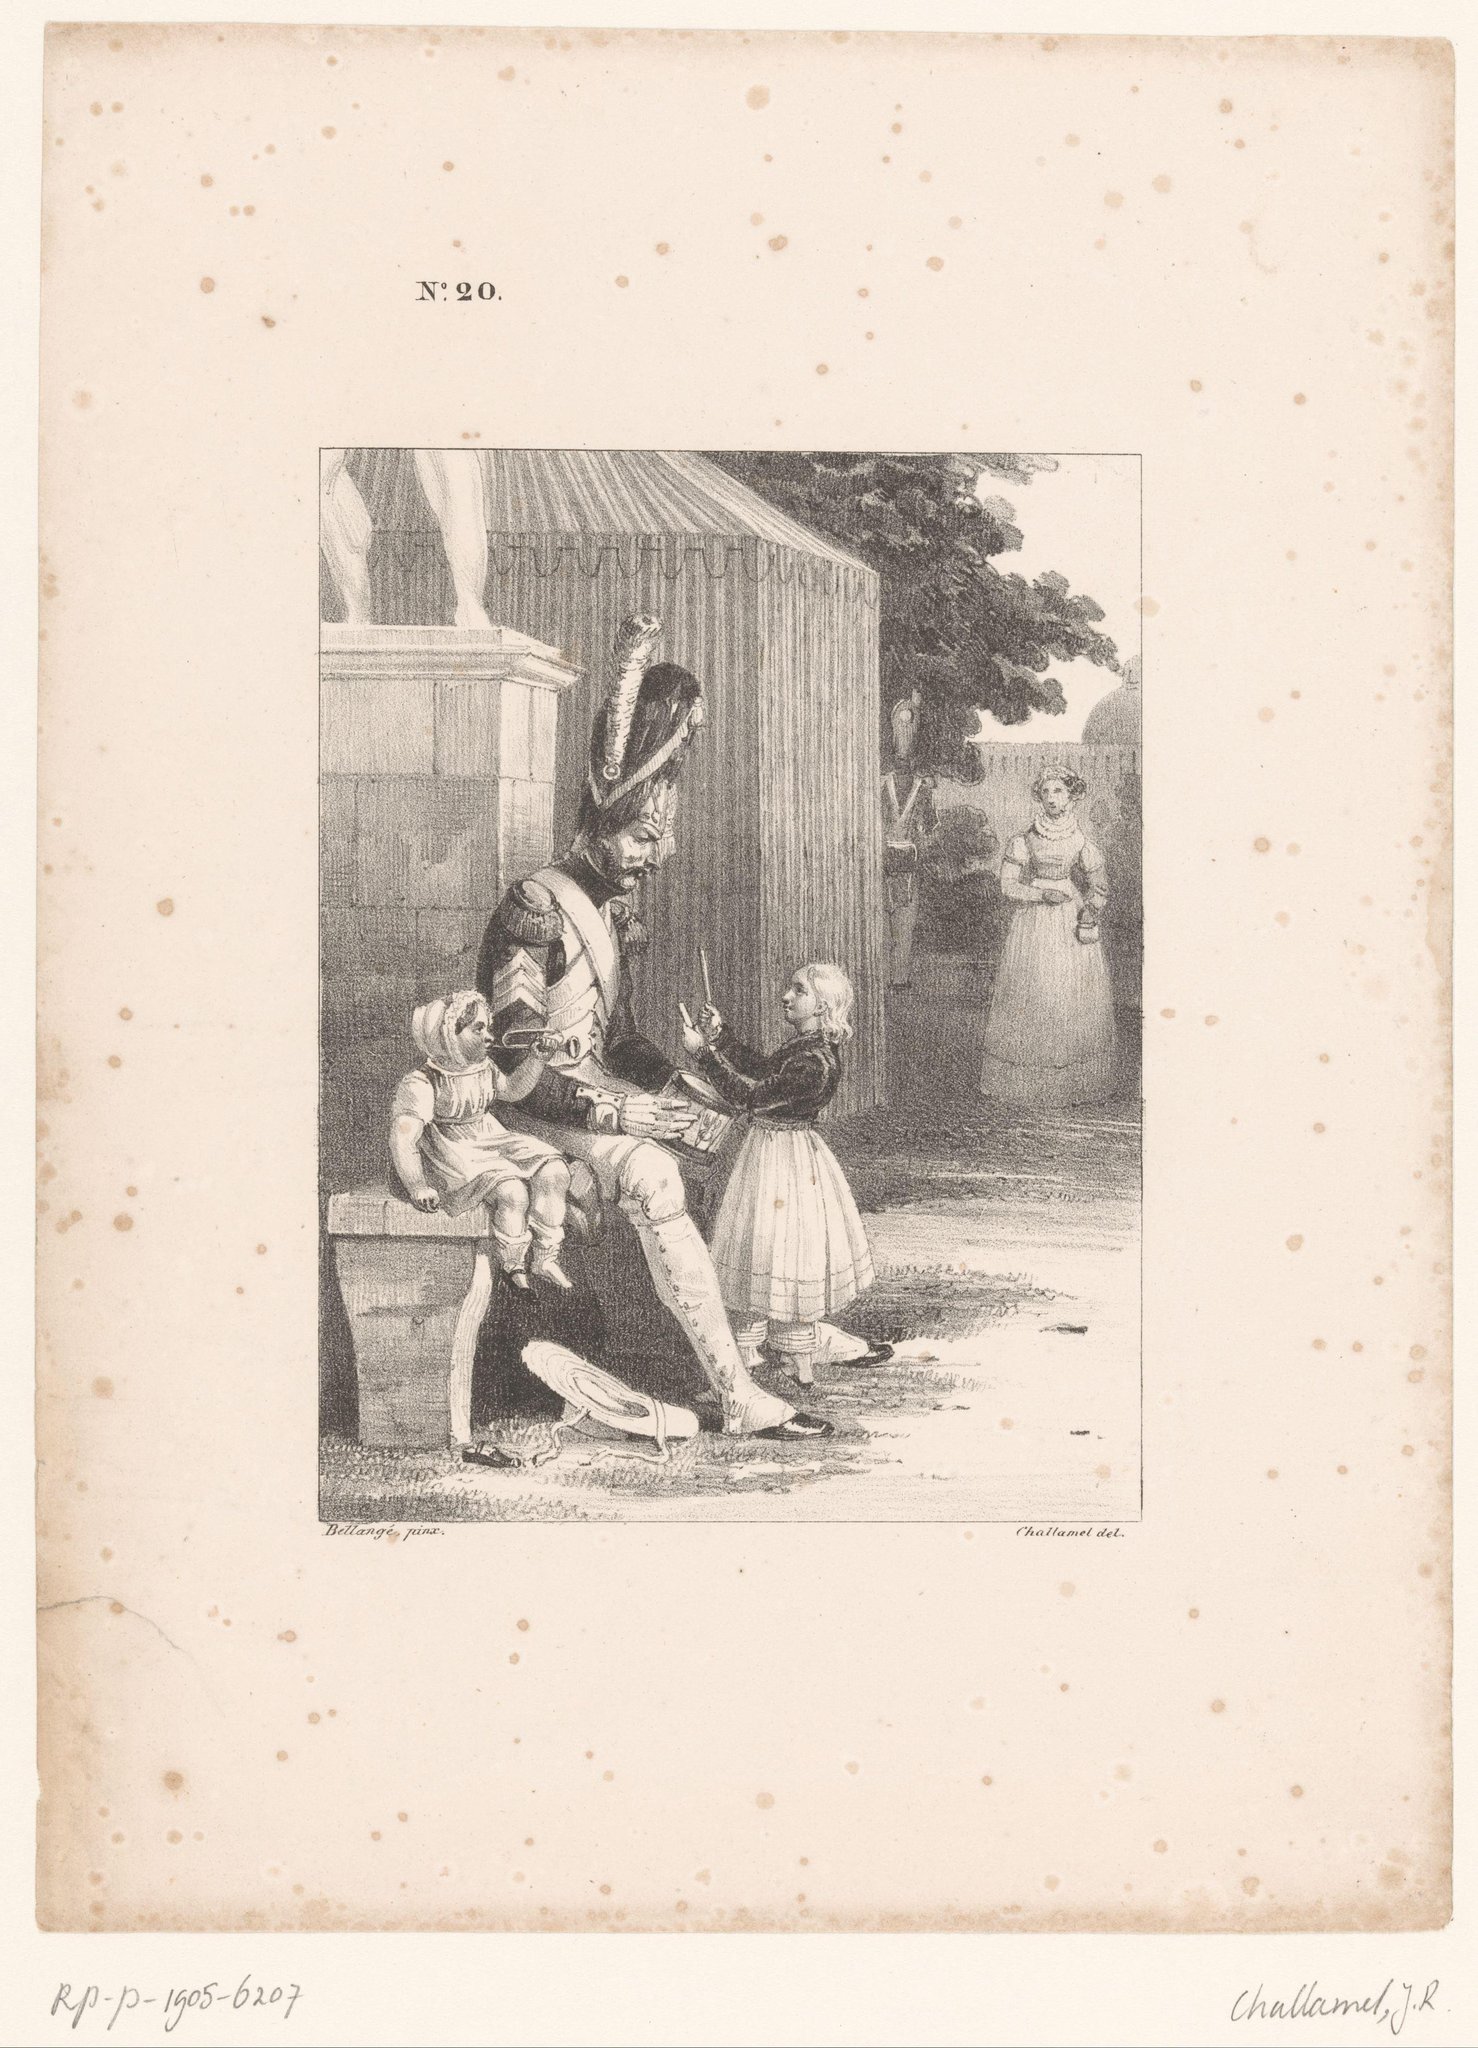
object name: print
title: Studie van een soldaat en twee kinderen met muziekinstrumenten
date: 1829-1862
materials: paper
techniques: lithograph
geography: paris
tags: the soldier off duty, 'music' of children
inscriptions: collector's mark: Lugt 2228a